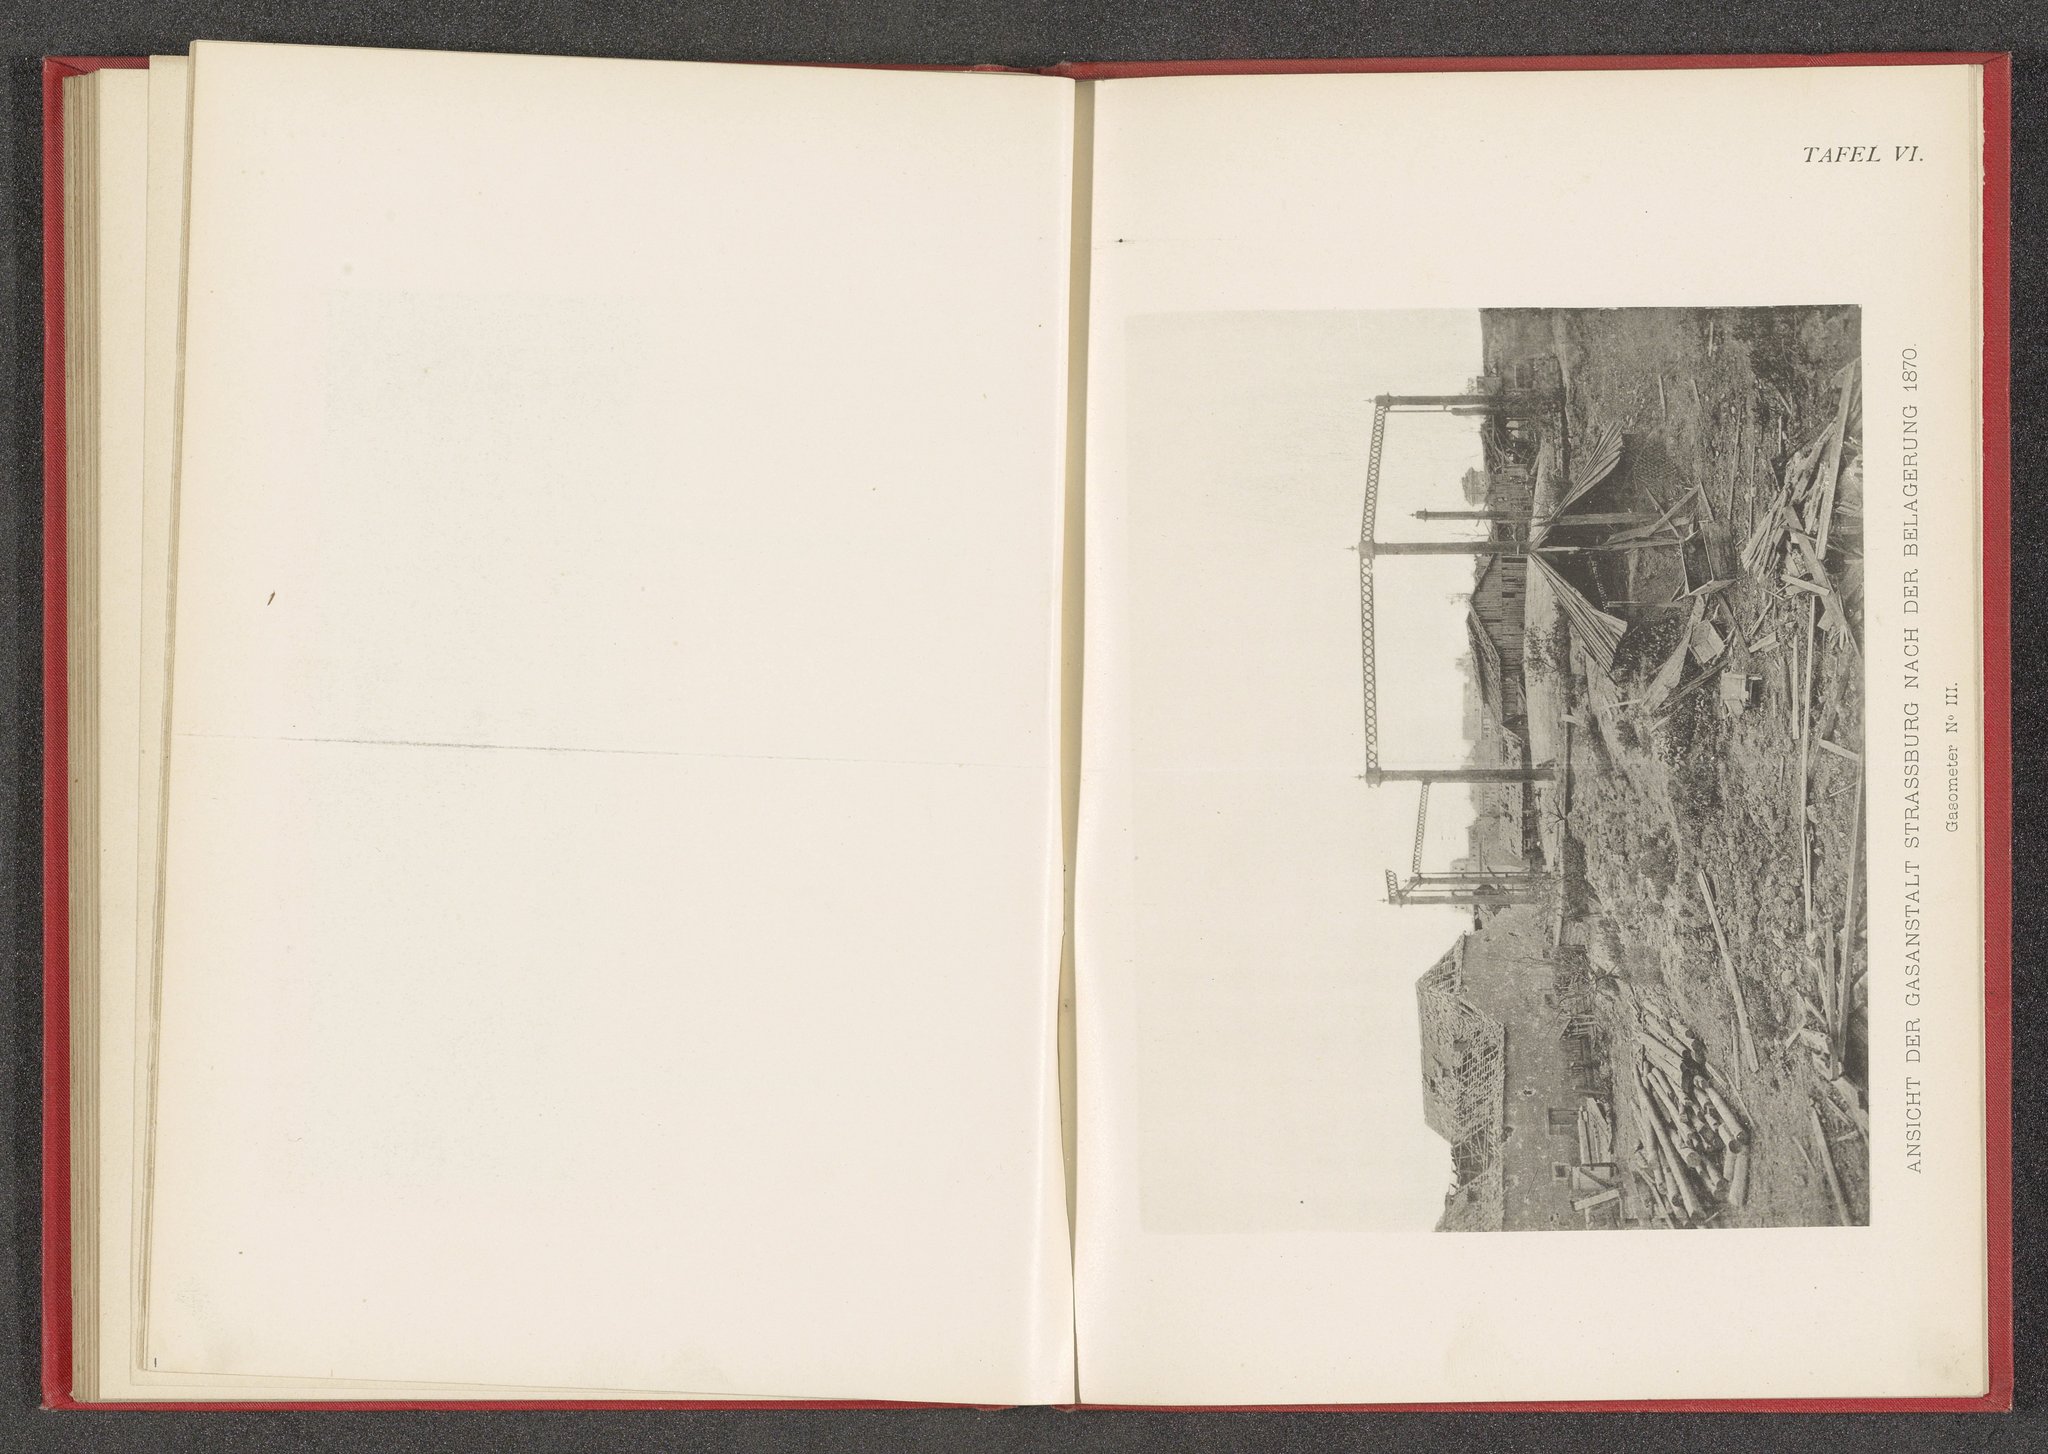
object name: page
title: Gezicht op resten van een gashouder van de gasfabriek in Straatsburg na de verwoesting tijdens het beleg in 1870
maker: Anonymous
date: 1870-1891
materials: paper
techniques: photograph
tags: gasworks, ruin of a building ~ architecture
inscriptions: inscription: ‘Gasometer No III.’, number: ‘Tafel VI.’